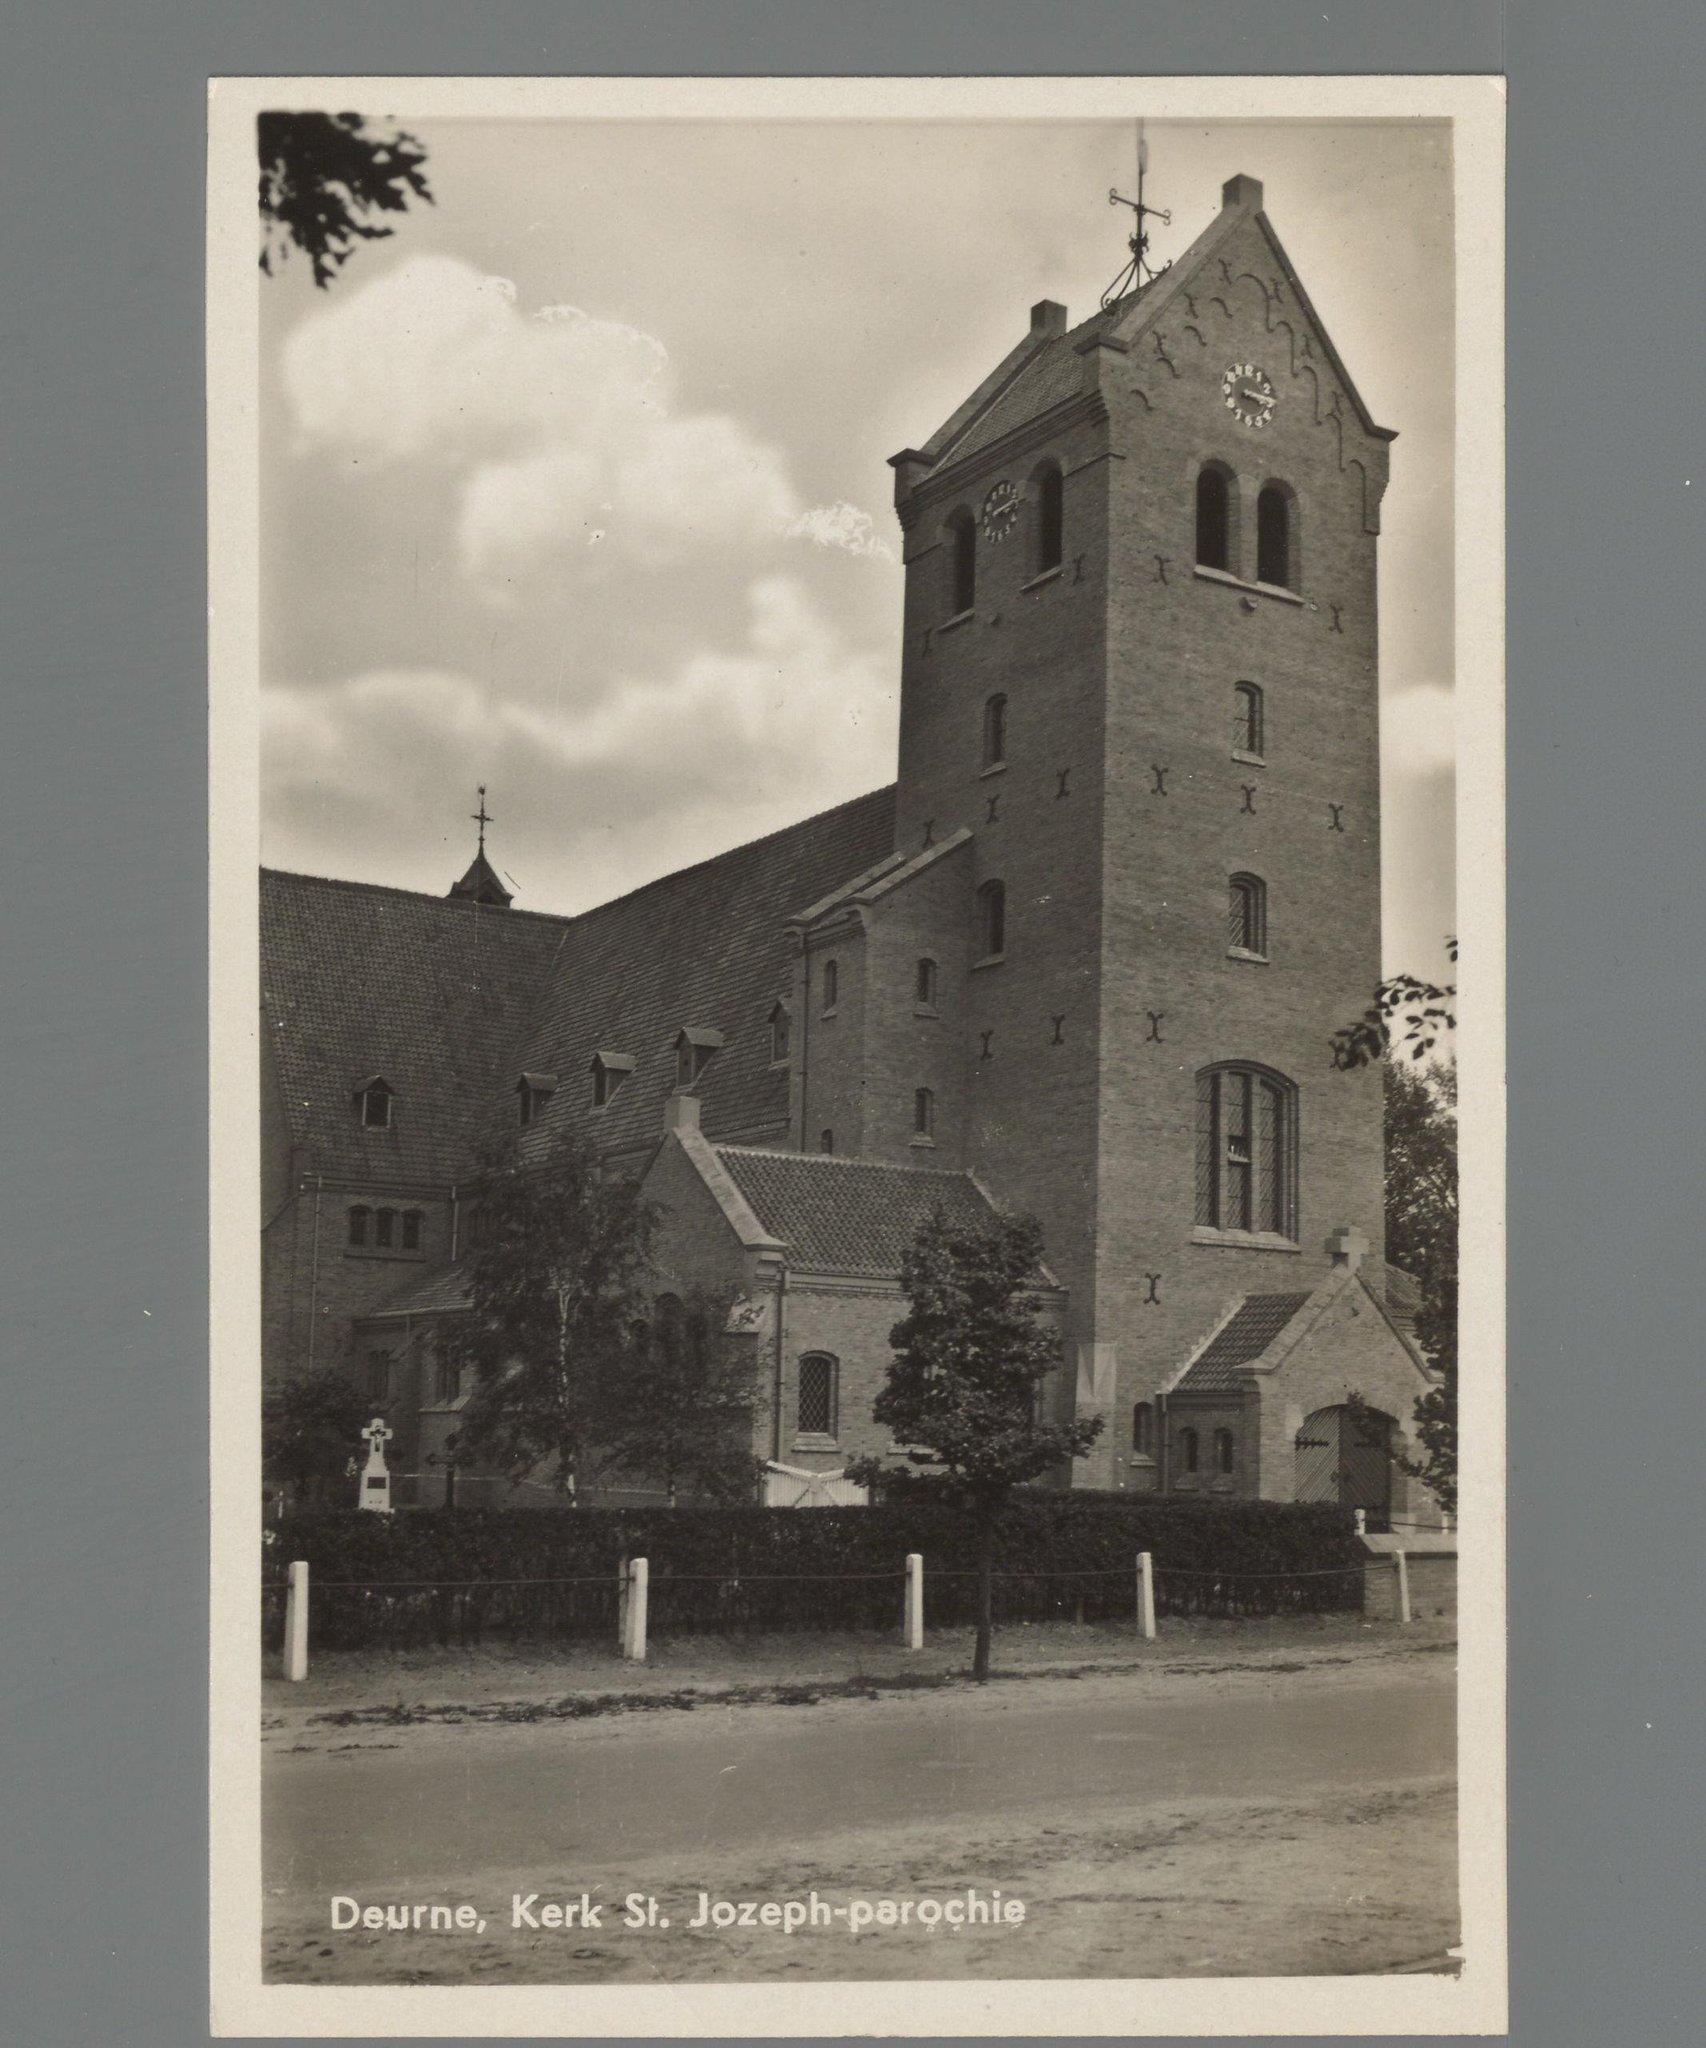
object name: photograph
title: Deurne, kerk St. Jozeph-parochie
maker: Anonymous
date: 1904-1940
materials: paper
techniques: gelatin silver print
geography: sint-jozefparochie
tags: church (exterior)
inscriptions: date